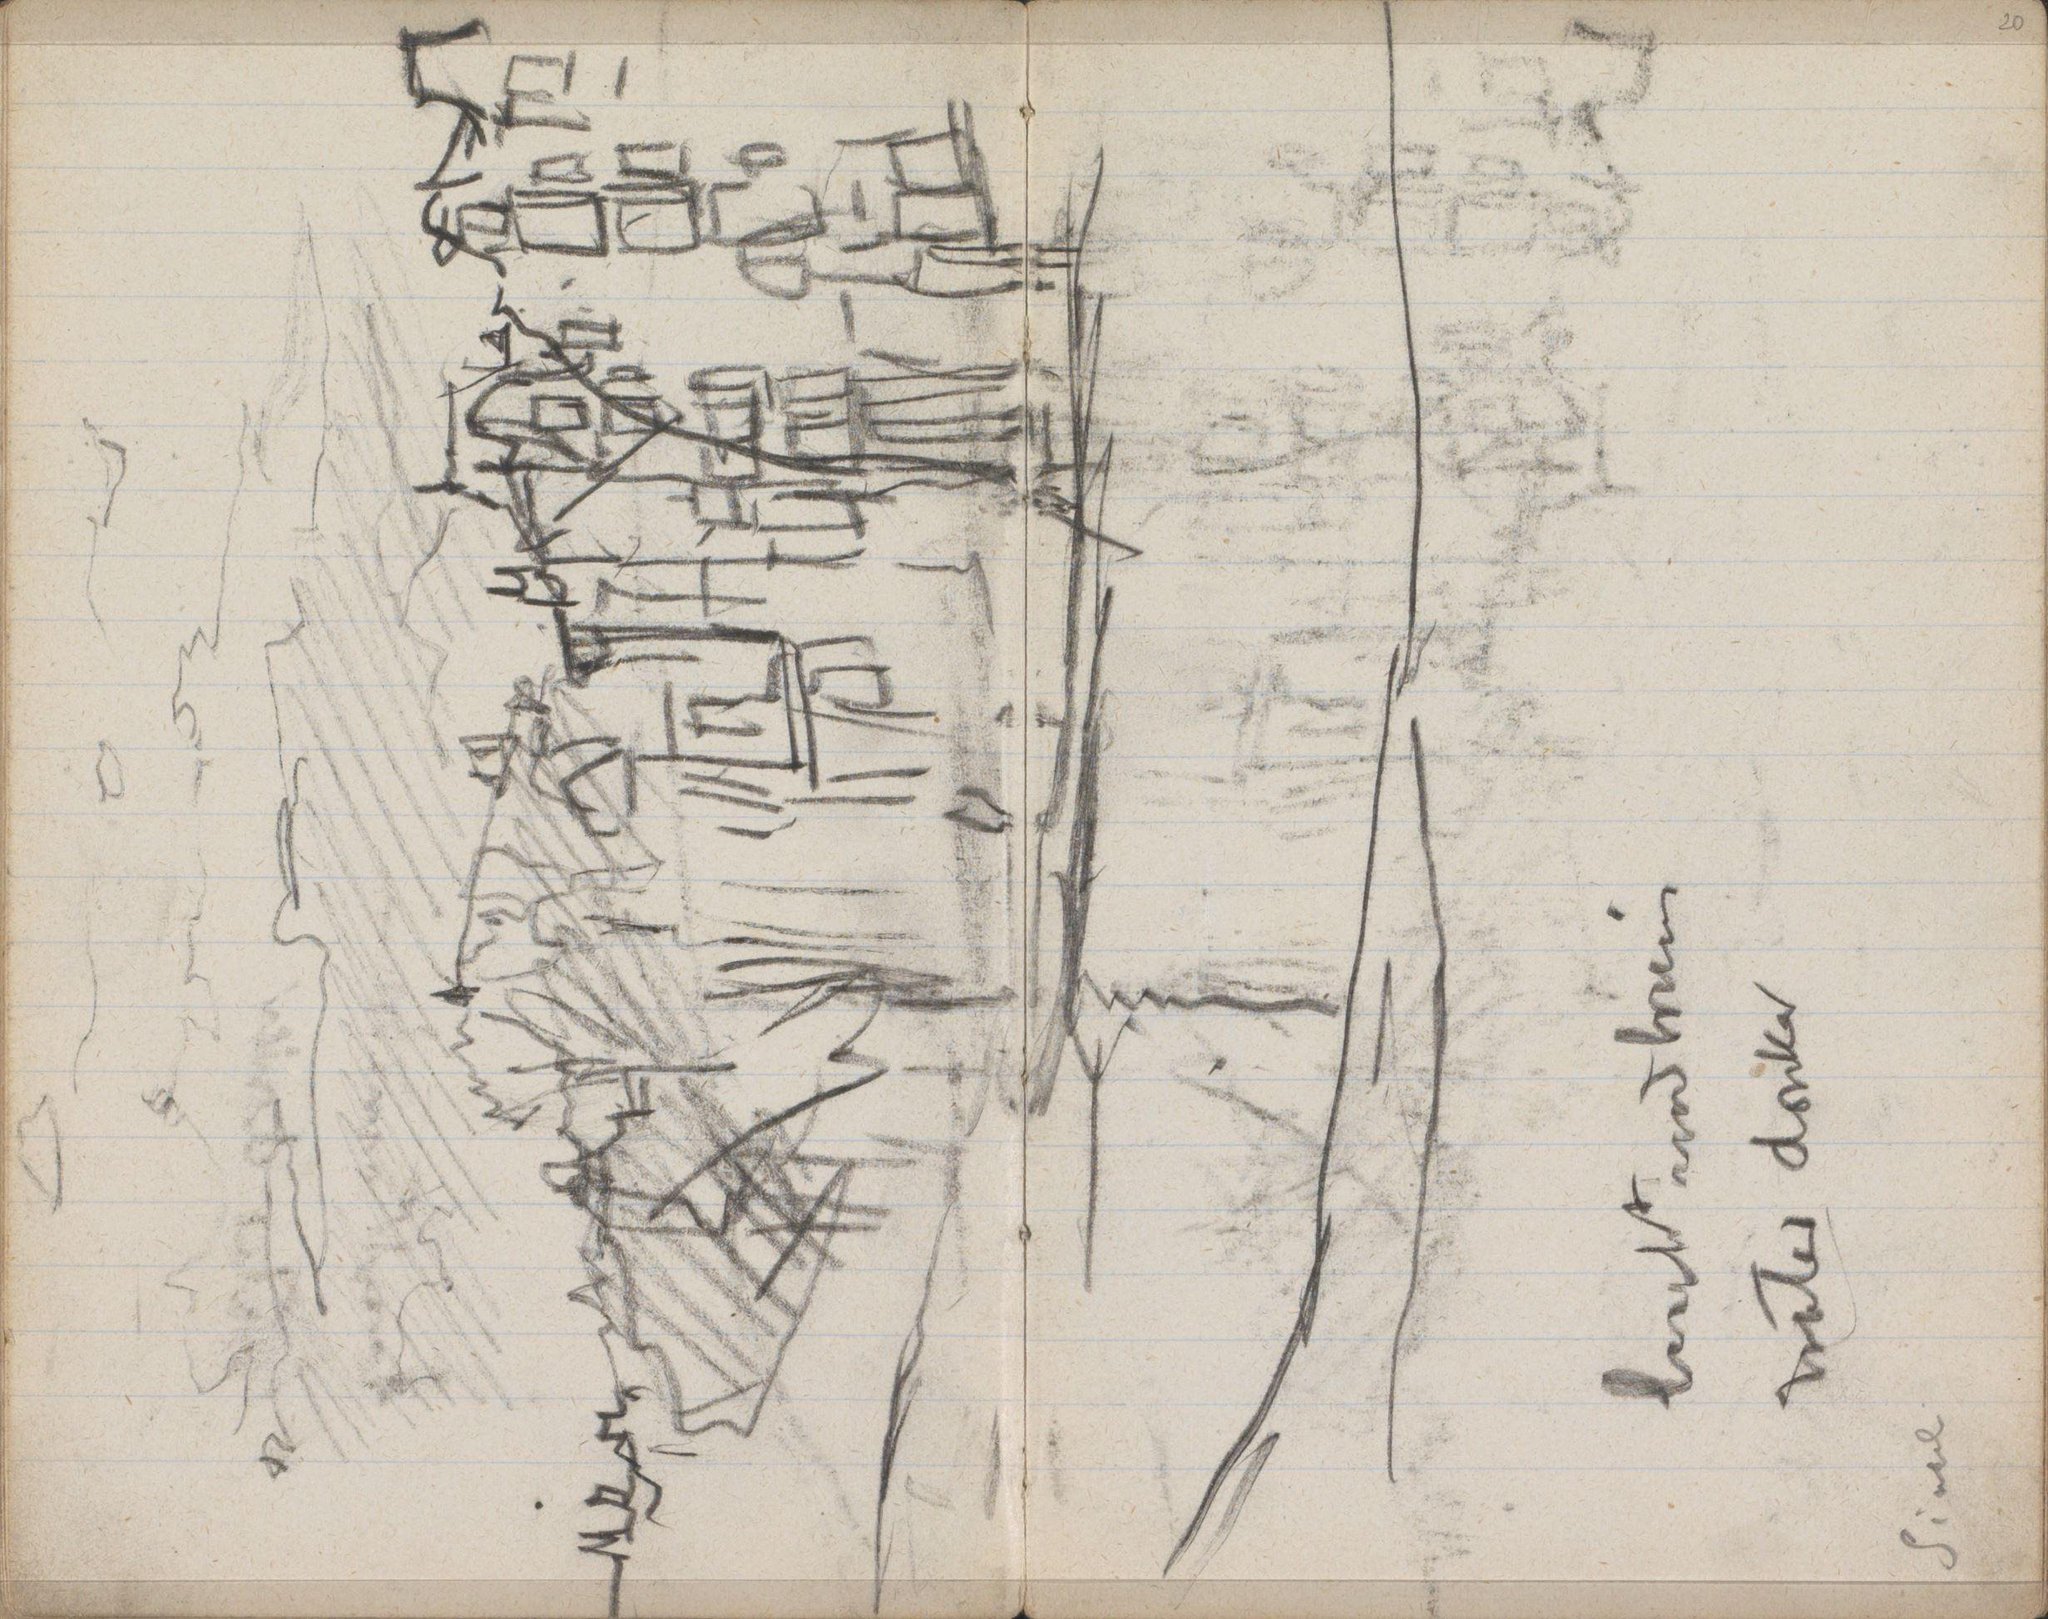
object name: sketchbook leaf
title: Gezicht op het Singel te Amsterdam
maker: george hendrik breitner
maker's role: draughtsman, painter, print maker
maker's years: 1857-1923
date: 1893-1898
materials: chalk, paper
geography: amsterdam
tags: civic architecture; edifices; dwellings, canals, waters (in city) (+ city(-scape) with figures, staffage)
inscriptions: : ‘lucht roodbruin/ water donker’, annotation: ‘Singel’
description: Pagina 19 en pagina 20 uit een schetsboek met 31 bladen.